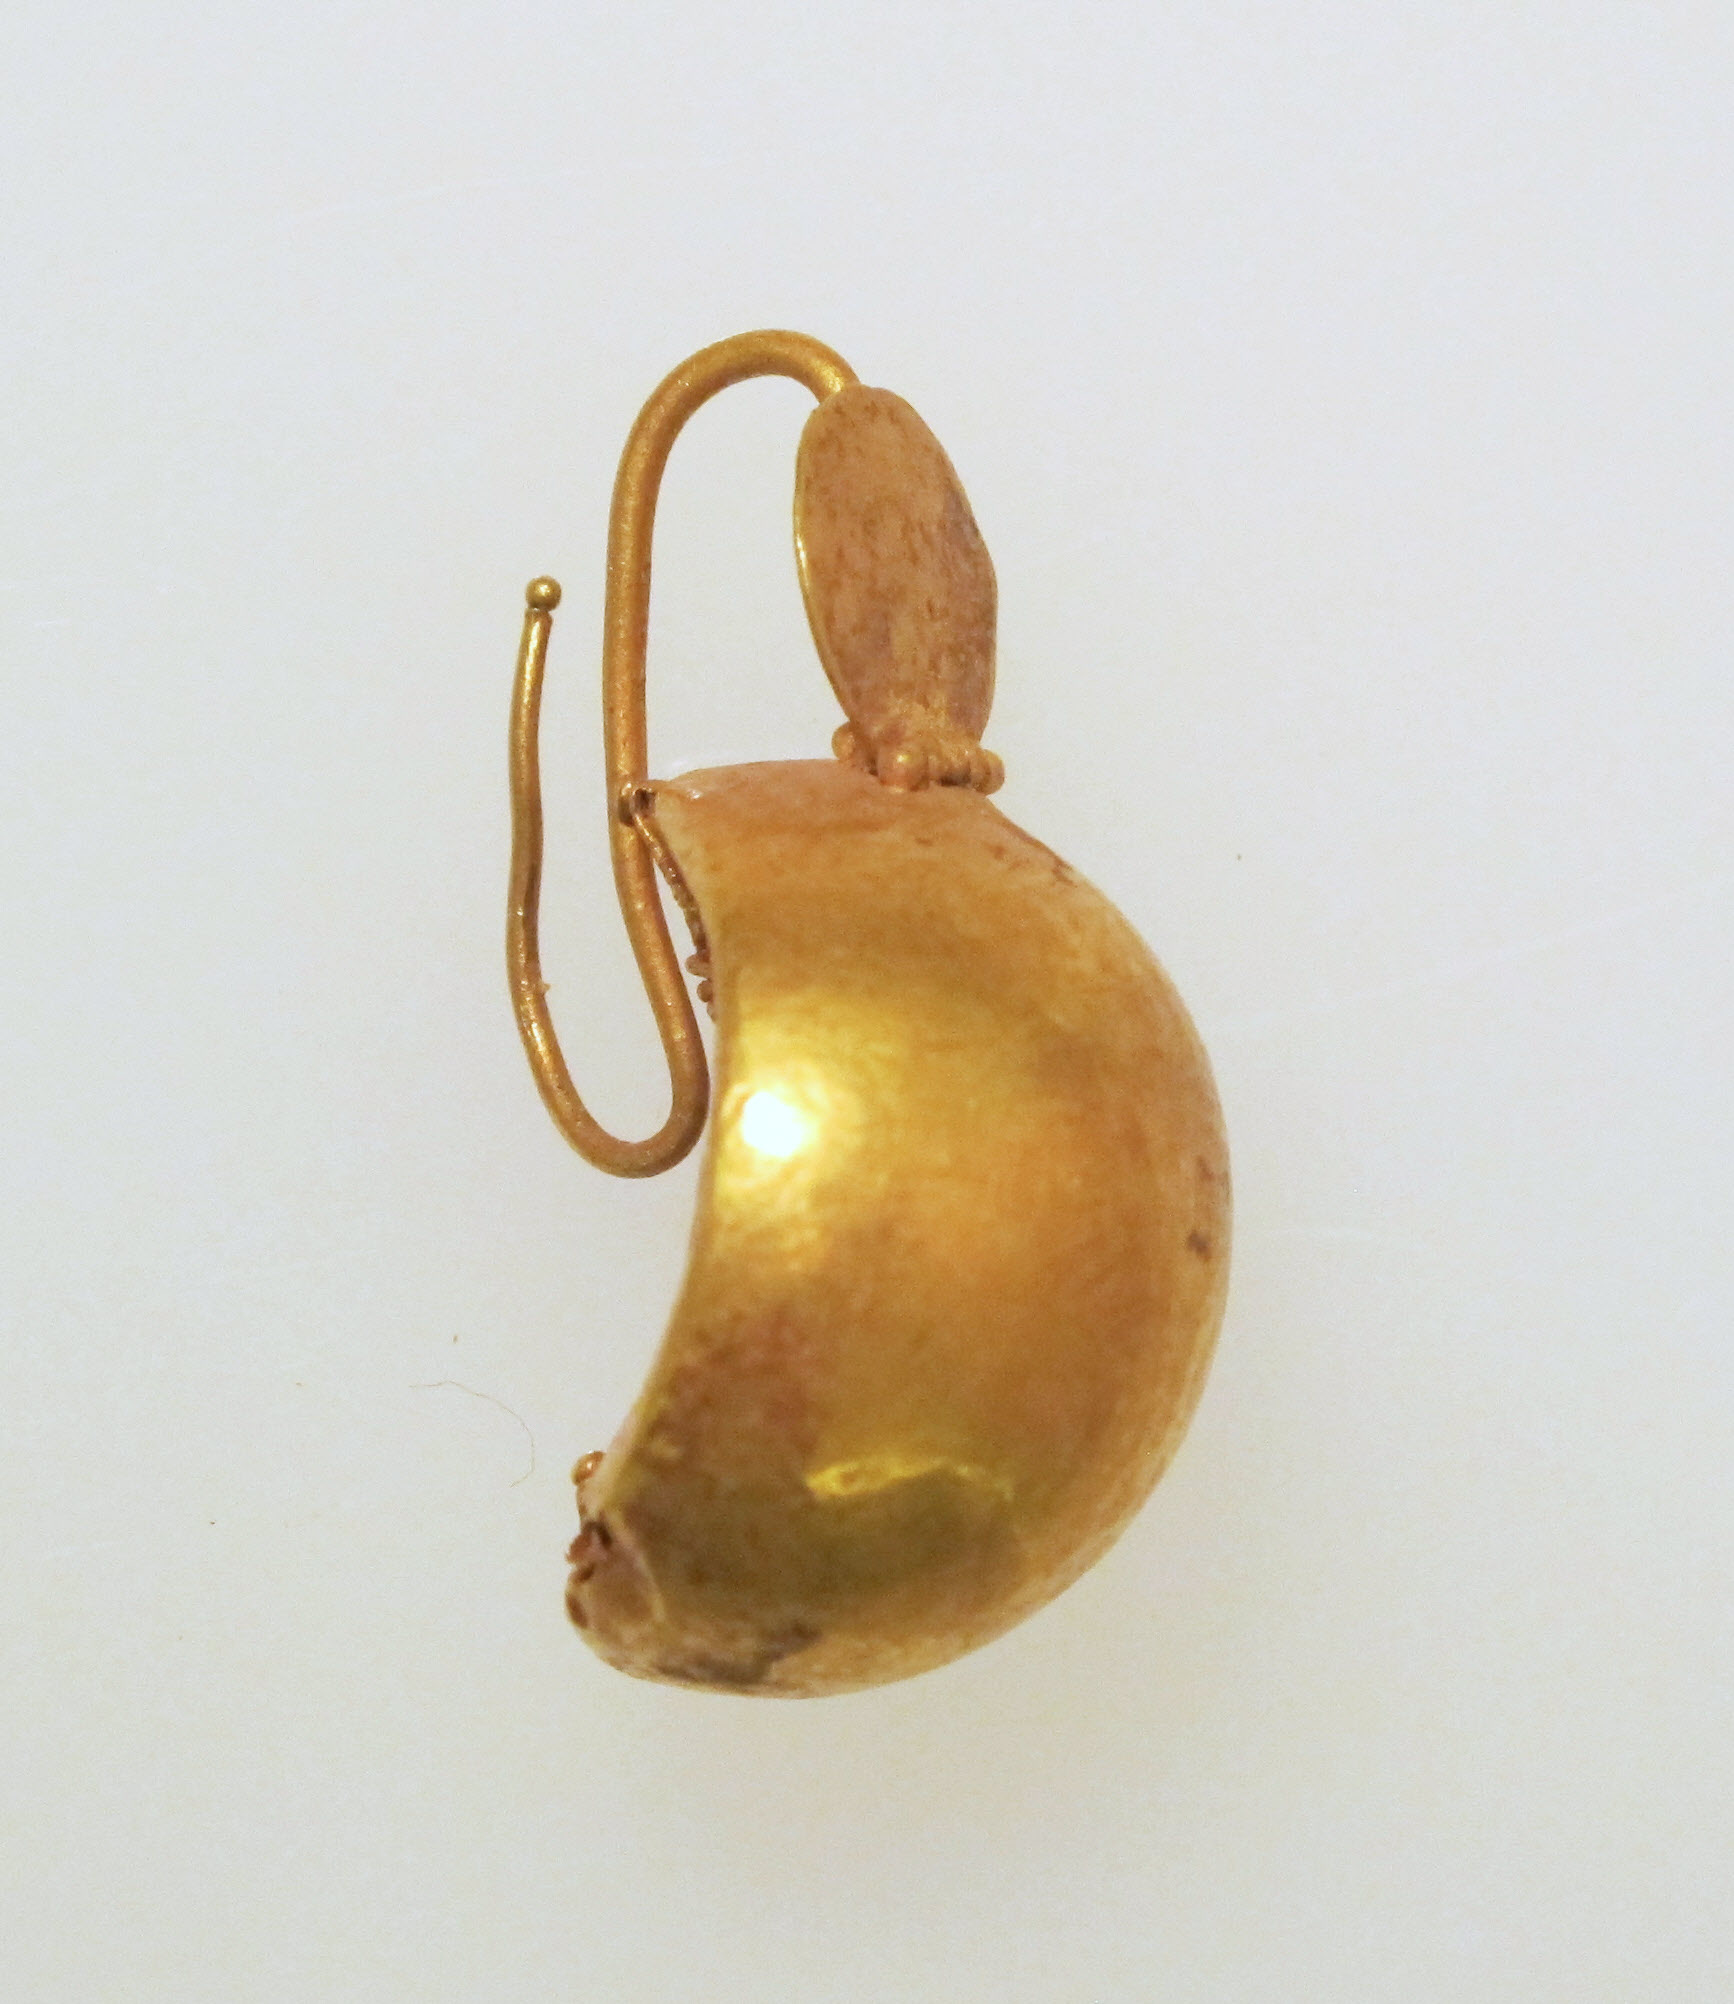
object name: earring hook type with disc of thin foil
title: Earring-hook type with discs of thin foil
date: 7000 BCE-330 CE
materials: gold